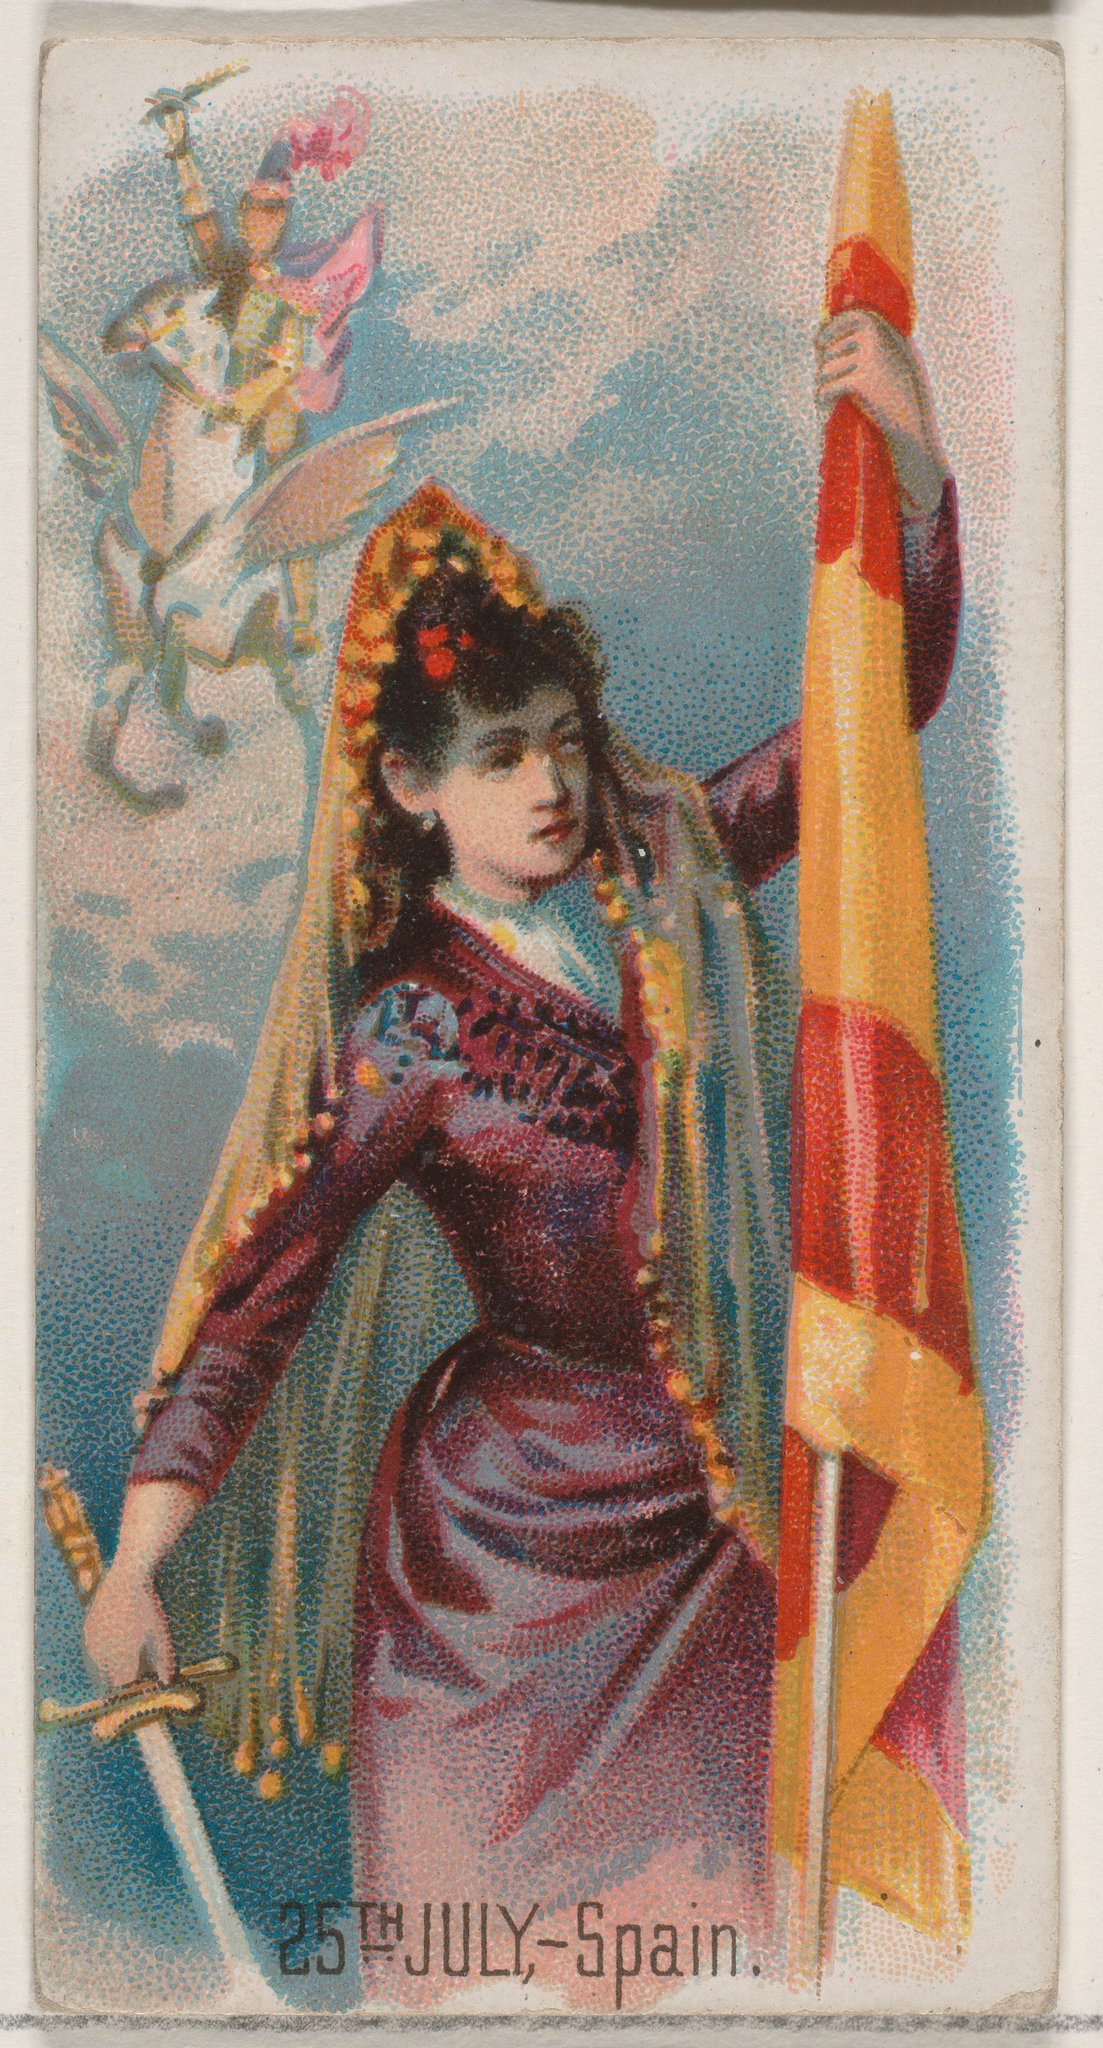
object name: print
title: 25th of July, Spain, from the Holidays series (N80) for Duke brand cigarettes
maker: w. duke, sons & co.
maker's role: publisher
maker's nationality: american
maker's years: 1870-1920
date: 1890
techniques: color lithograph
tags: women